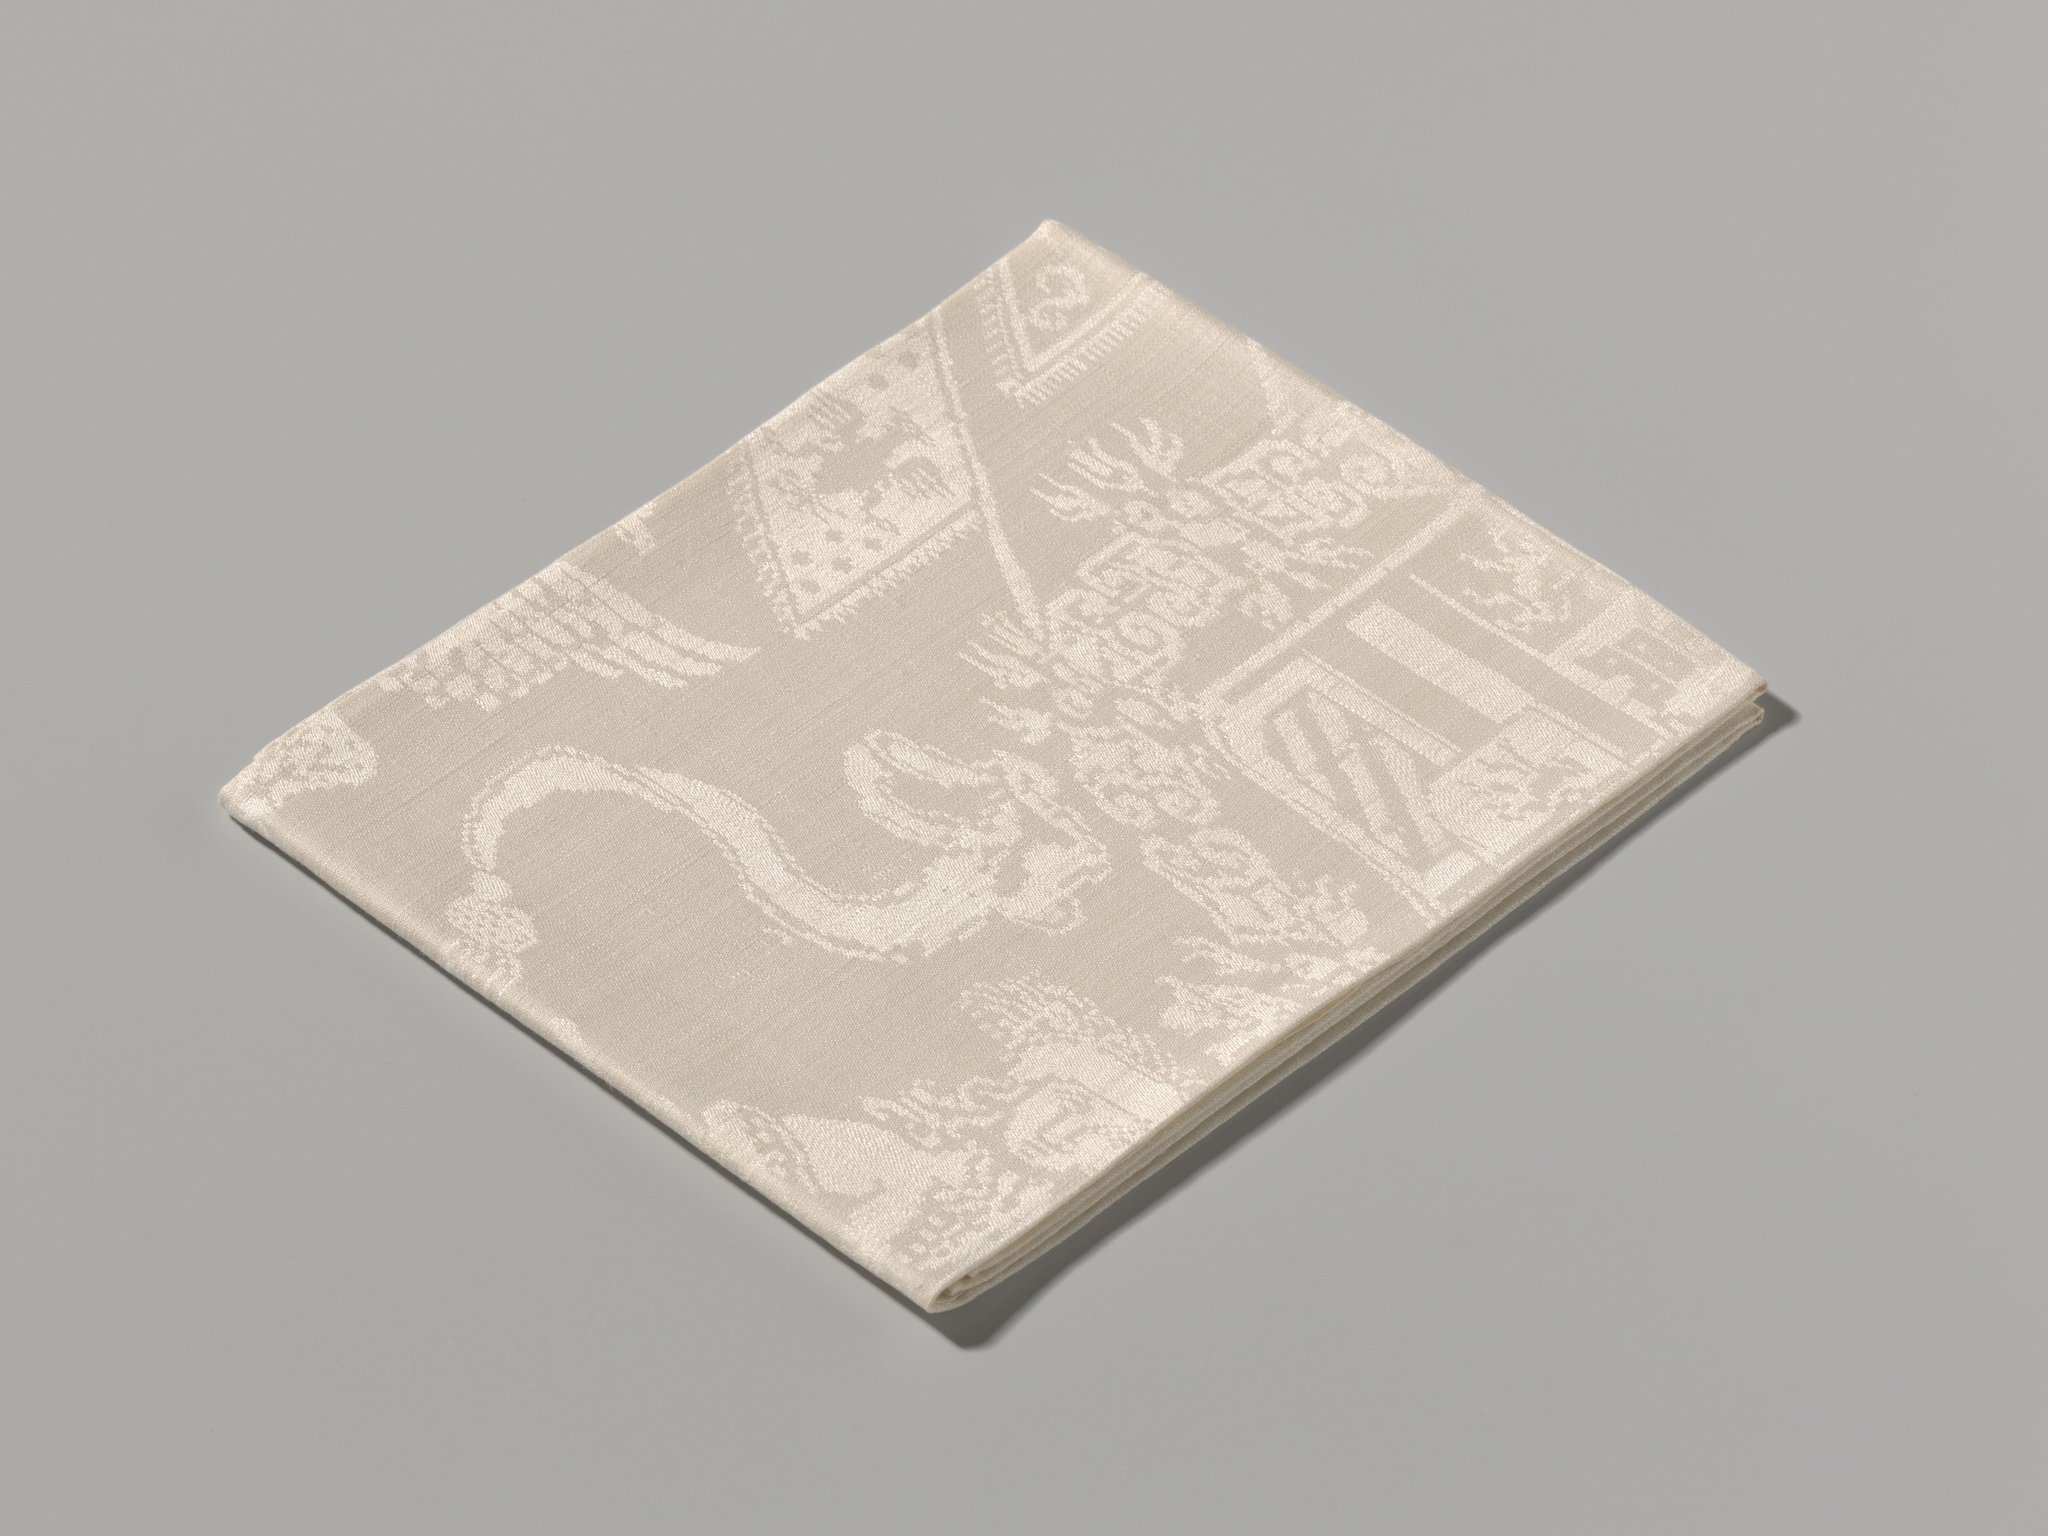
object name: napkin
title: Servet met het wapen van Karel III van Spanje en een gezicht op Rijssel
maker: Anonymous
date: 1702-1713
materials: linen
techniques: damask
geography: kortrijk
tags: vienna, charles vi (holy roman emperor), lille, spain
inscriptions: mark: ‘13’, mark: ‘? S’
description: Servet van linnendamast met het wapen van Karel III van Spanje en een gezicht op Rijssel. Het symmetrisch patroon vertoont van onder naar boven de volgende taferelen: 1 Een gezicht op Rijssel met vele torens. 2 Plattegrond van een vesting met bovenschrift LILLE. 3 Ruiter te paard (Karel III van Spanje?). 4 Het wapen van Karel III van Spanje geflankeerd door vaandels. Staande en liggende randen: wapens, onder andere Savoye, en wapentrofeeën; daarbuiten: blokkenrand.